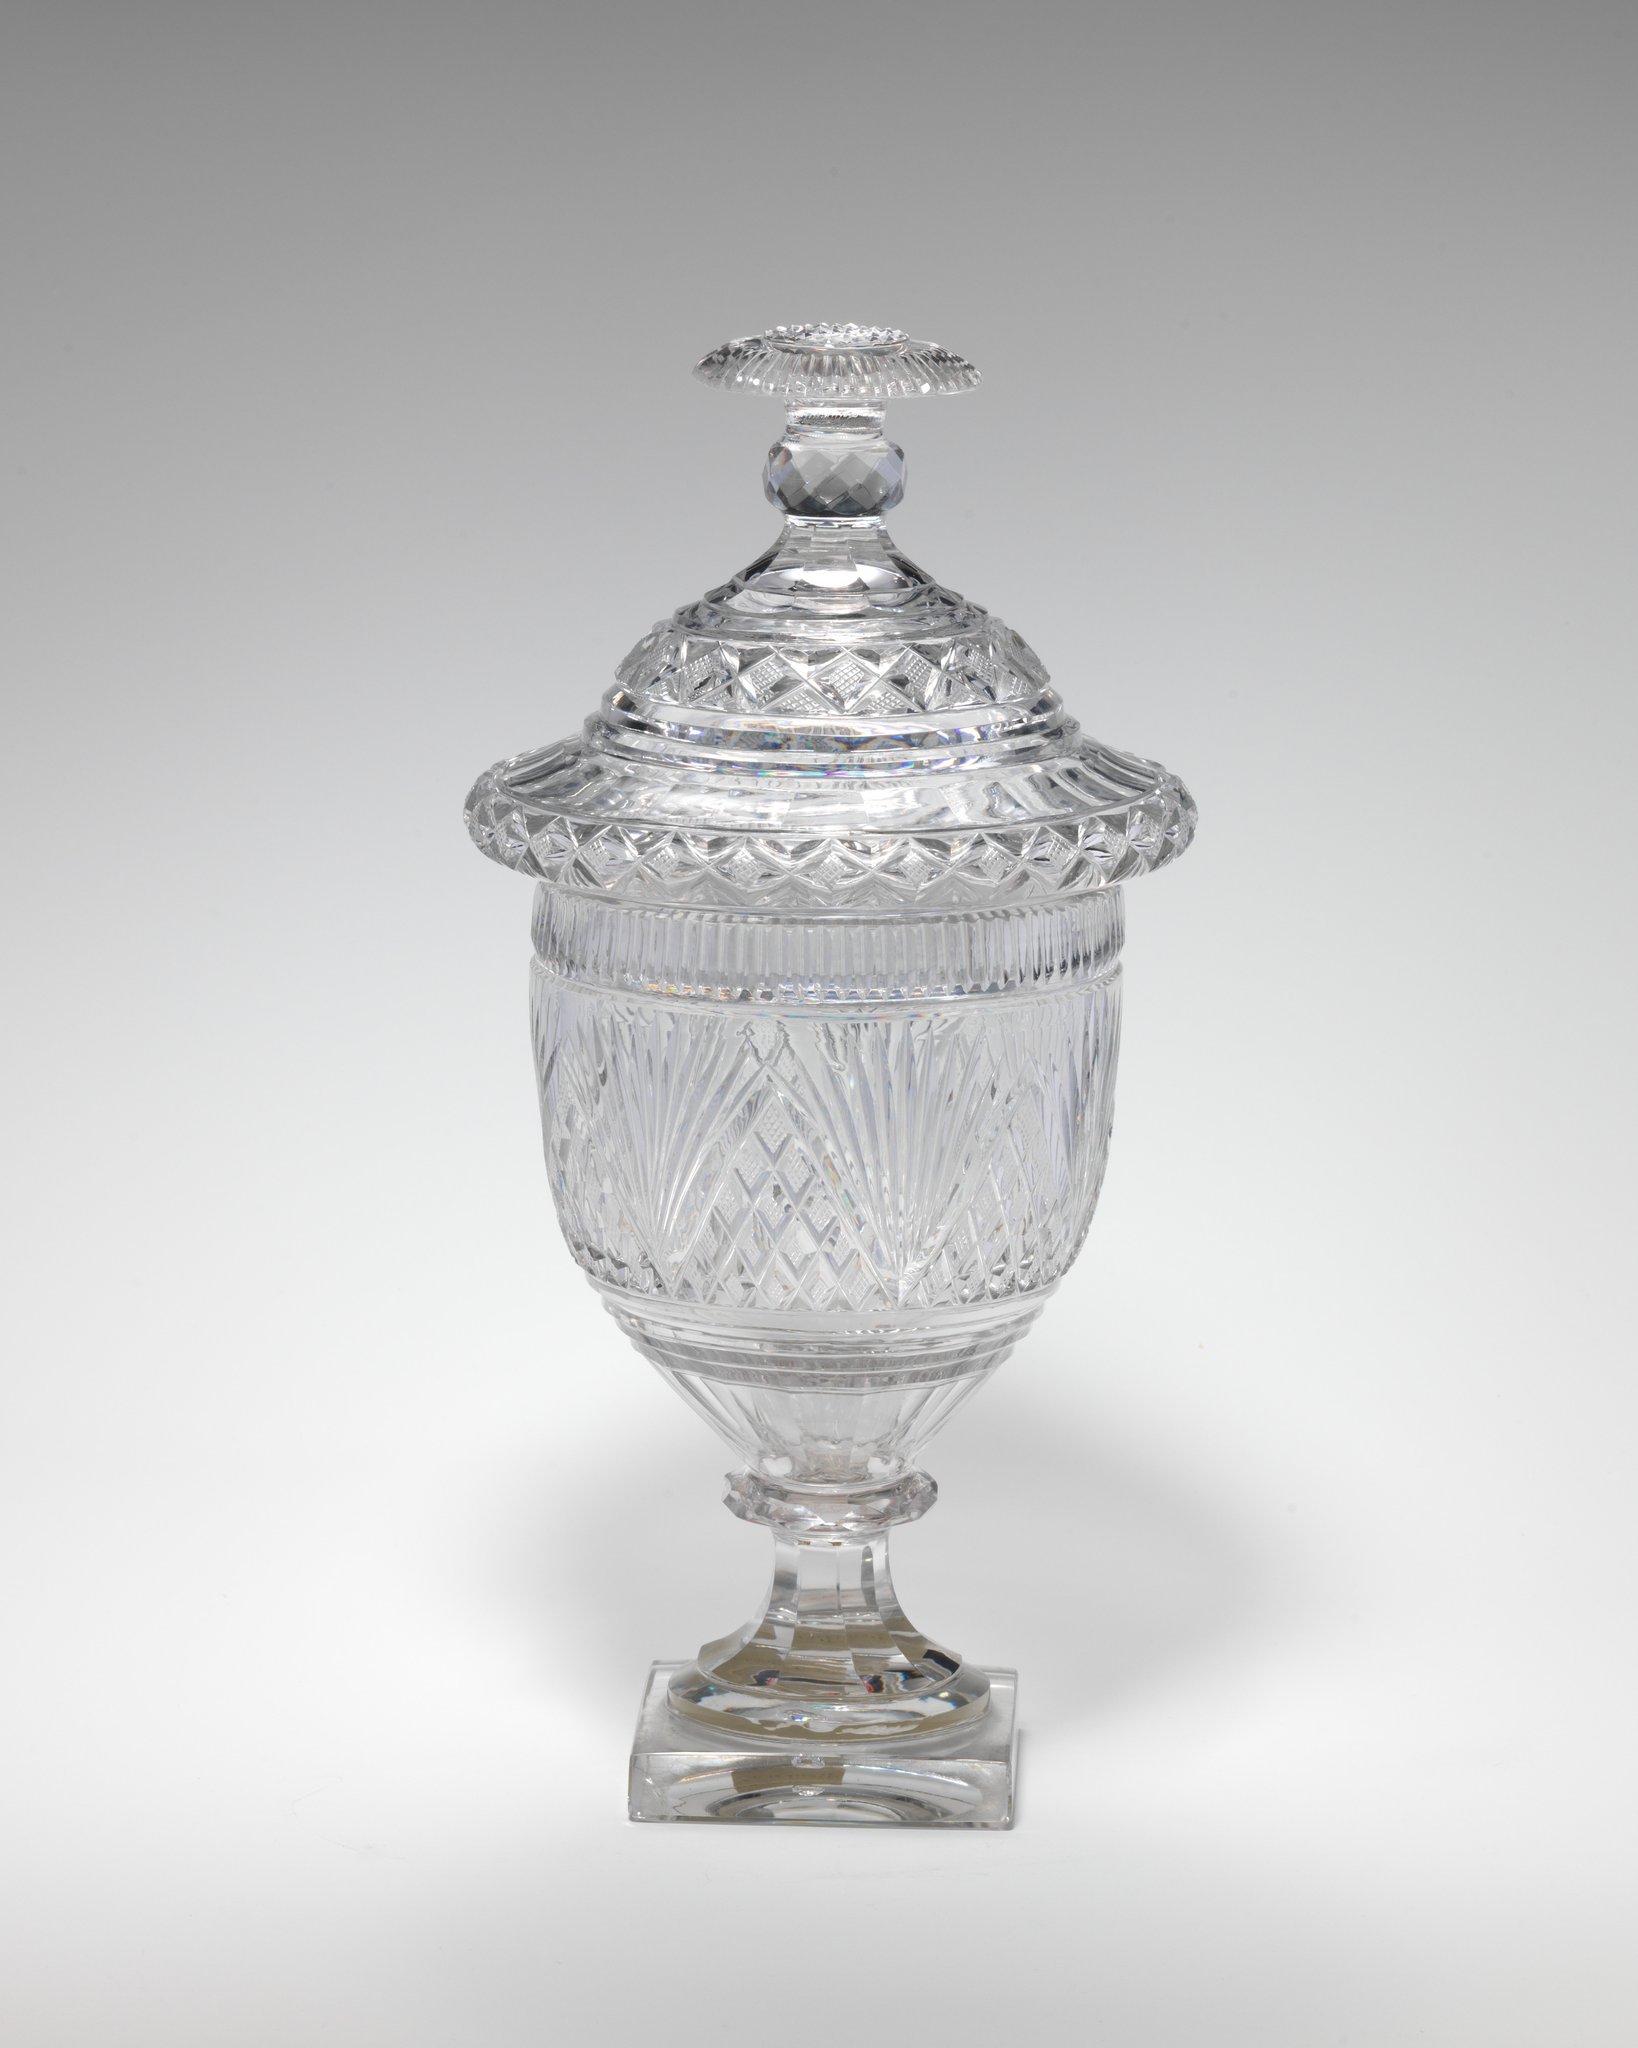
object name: urn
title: Urn (one of a pair)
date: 1800-1815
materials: glass